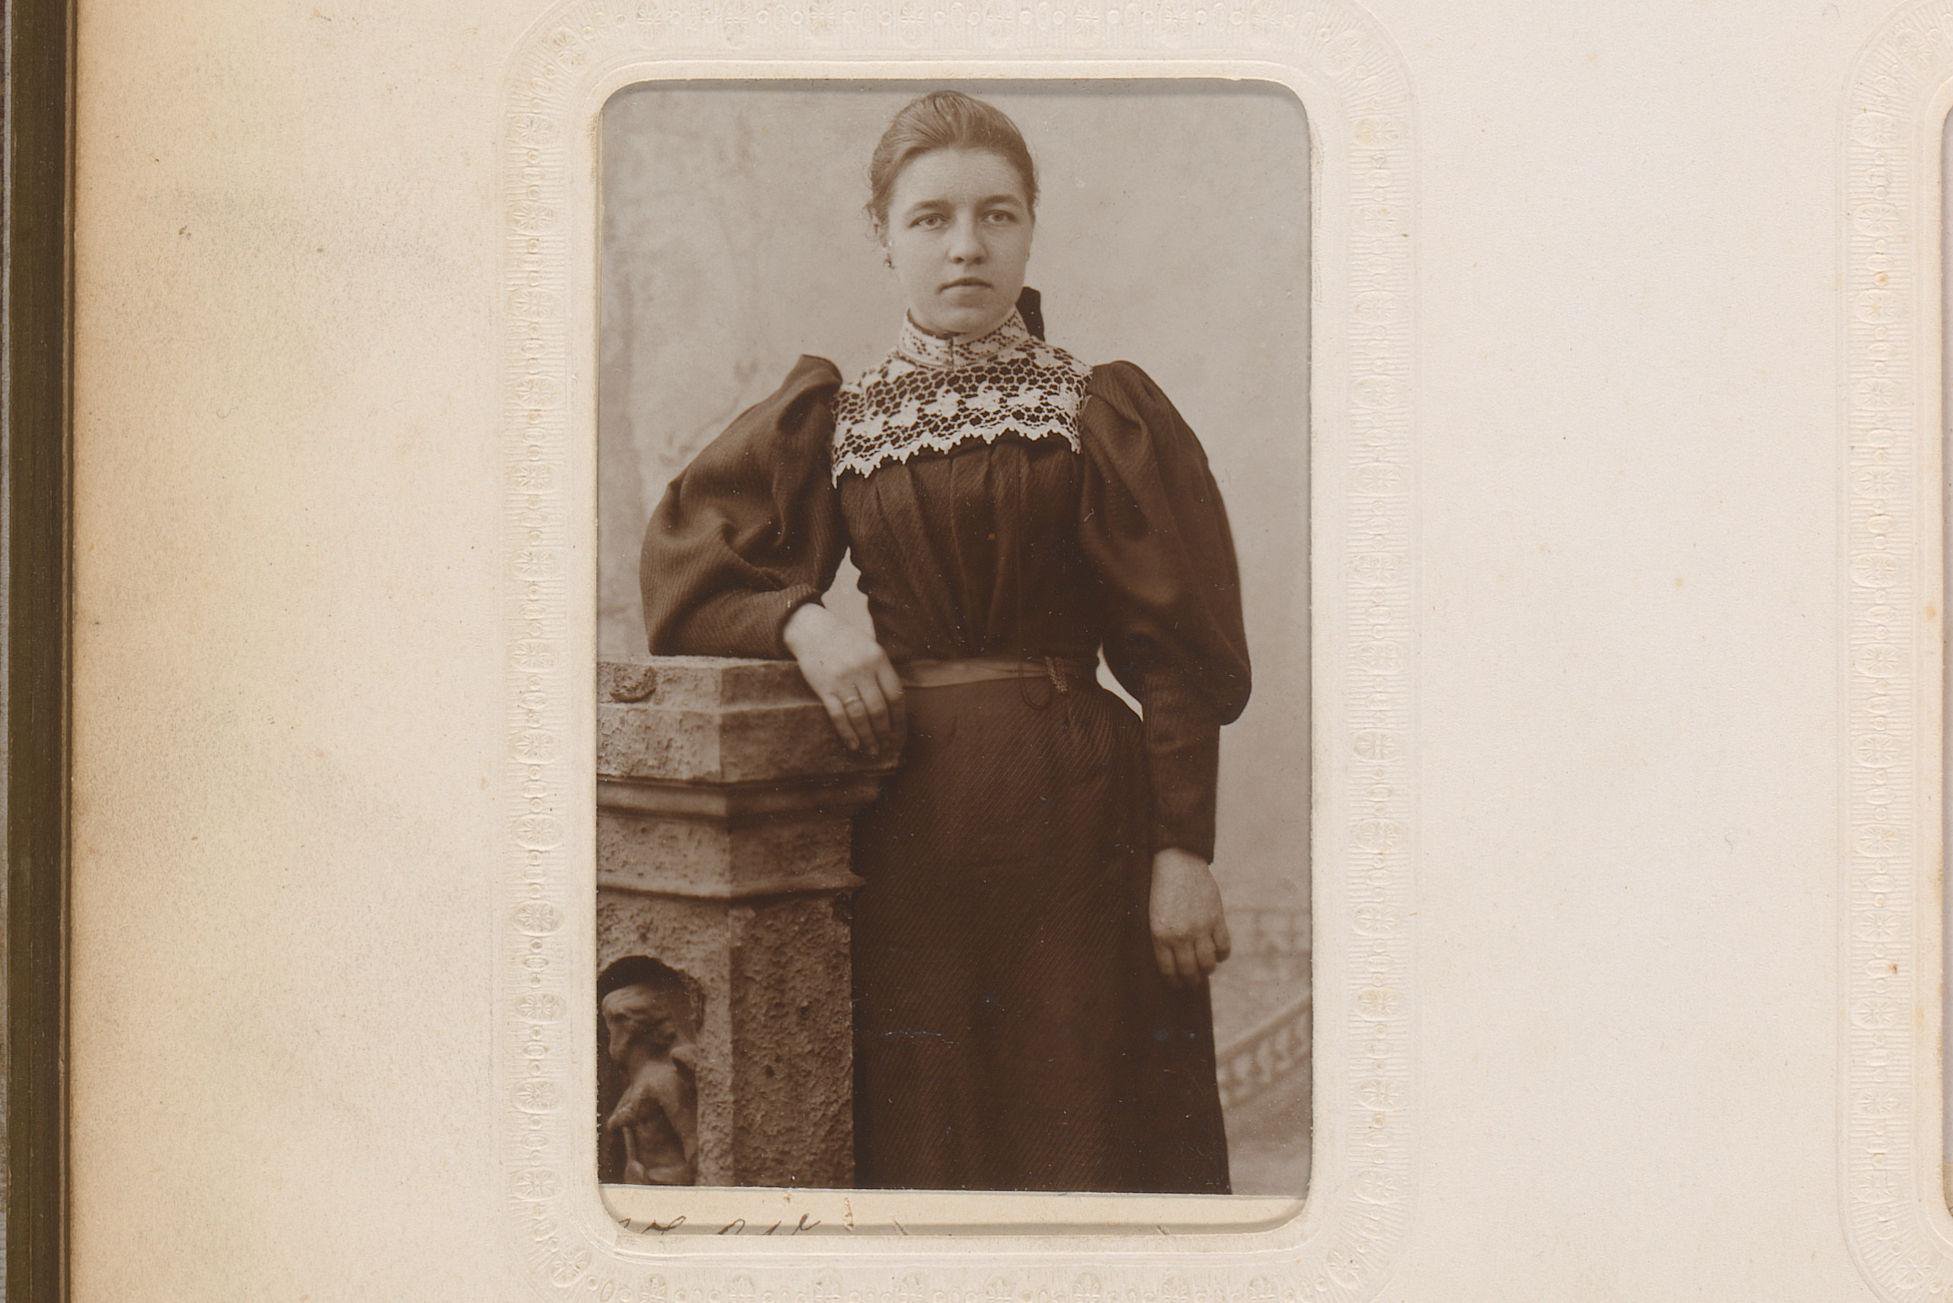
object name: album leaf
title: Portret van een vrouw, staand bij een zuil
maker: cornelis johannes lodewicus vermeulen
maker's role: fotograaf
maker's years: 1861-1936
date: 1878-1896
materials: cardboard, photographic support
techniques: collodion silver print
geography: amsterdam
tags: historical persons - bb - woman, pedestal of a piece of sculpture (perhaps in the form of a herm), standing figure - aa - female human figure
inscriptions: inscription: ‘C.J.L. Vermeulen - Amsterdam’